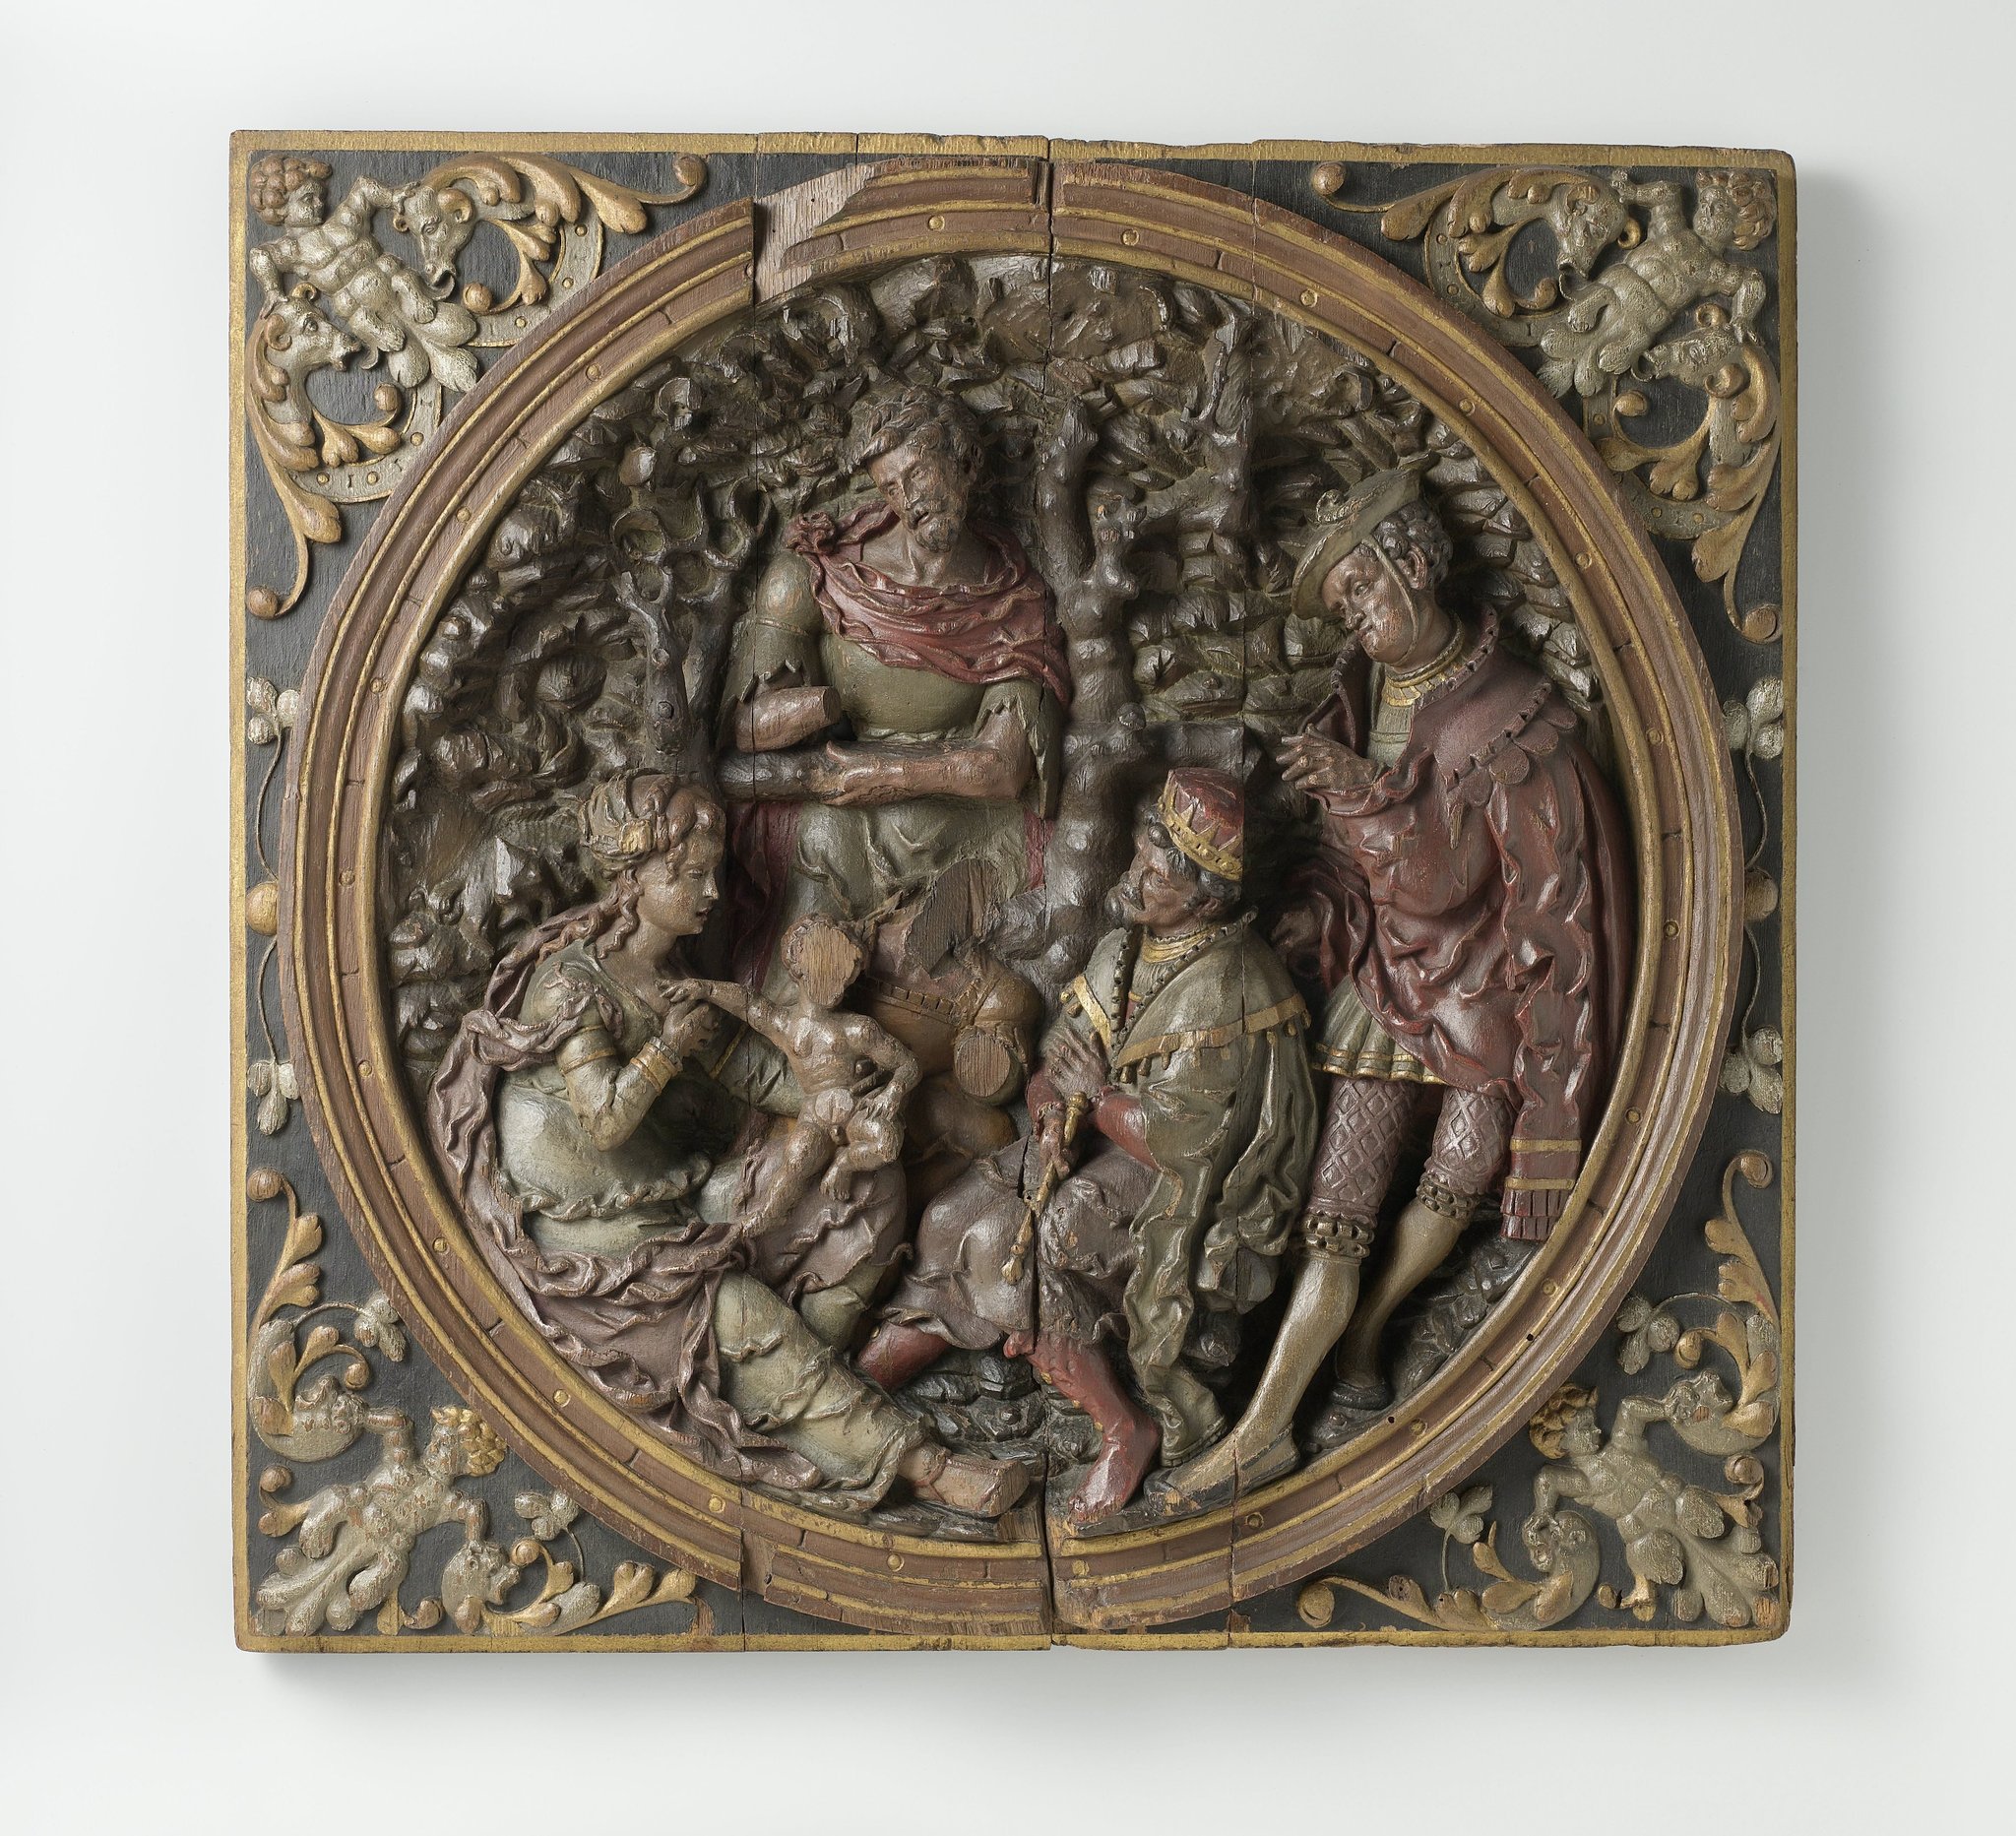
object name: sculpture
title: The Adoration of the Magi with St John the Baptist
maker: Anonymous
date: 1535-1565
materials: wood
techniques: polychromy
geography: gouda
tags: gouda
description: The Adoration of the Kings(?). Oak, original polychromy. Holland, c. 1530-1540. From St. John's Church, Gouda.